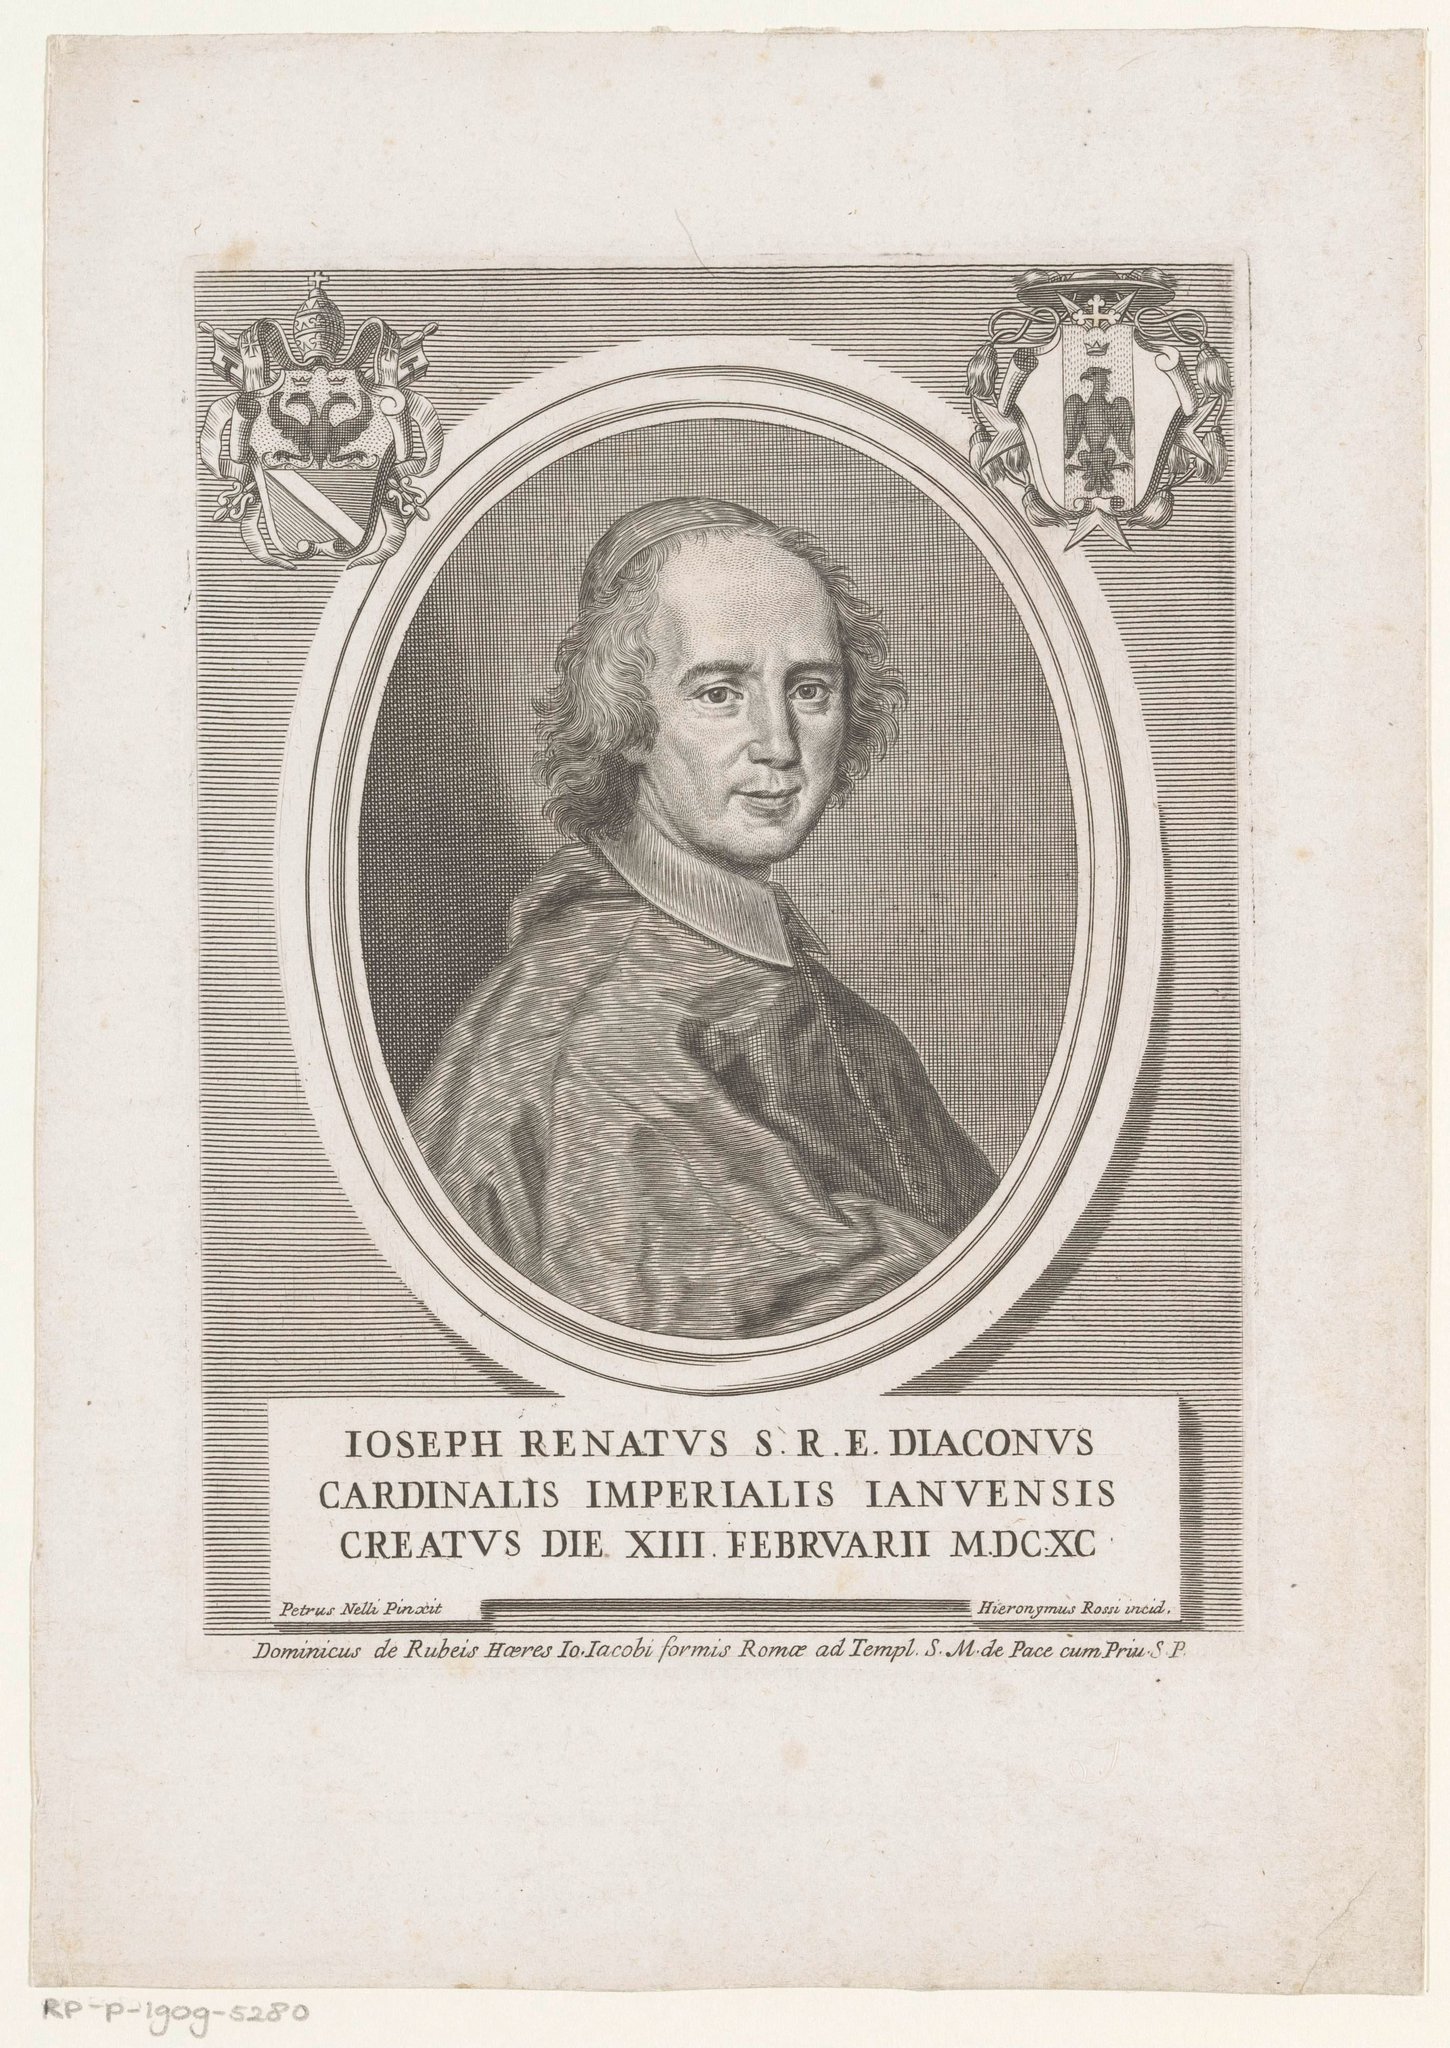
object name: print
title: Portret van kardinaal Giuseppe Renato Imperiali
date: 1690-1762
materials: paper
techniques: engraving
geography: italy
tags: giuseppe renato imperiali, cardinal, historical persons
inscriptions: collector's mark: Lugt 2228